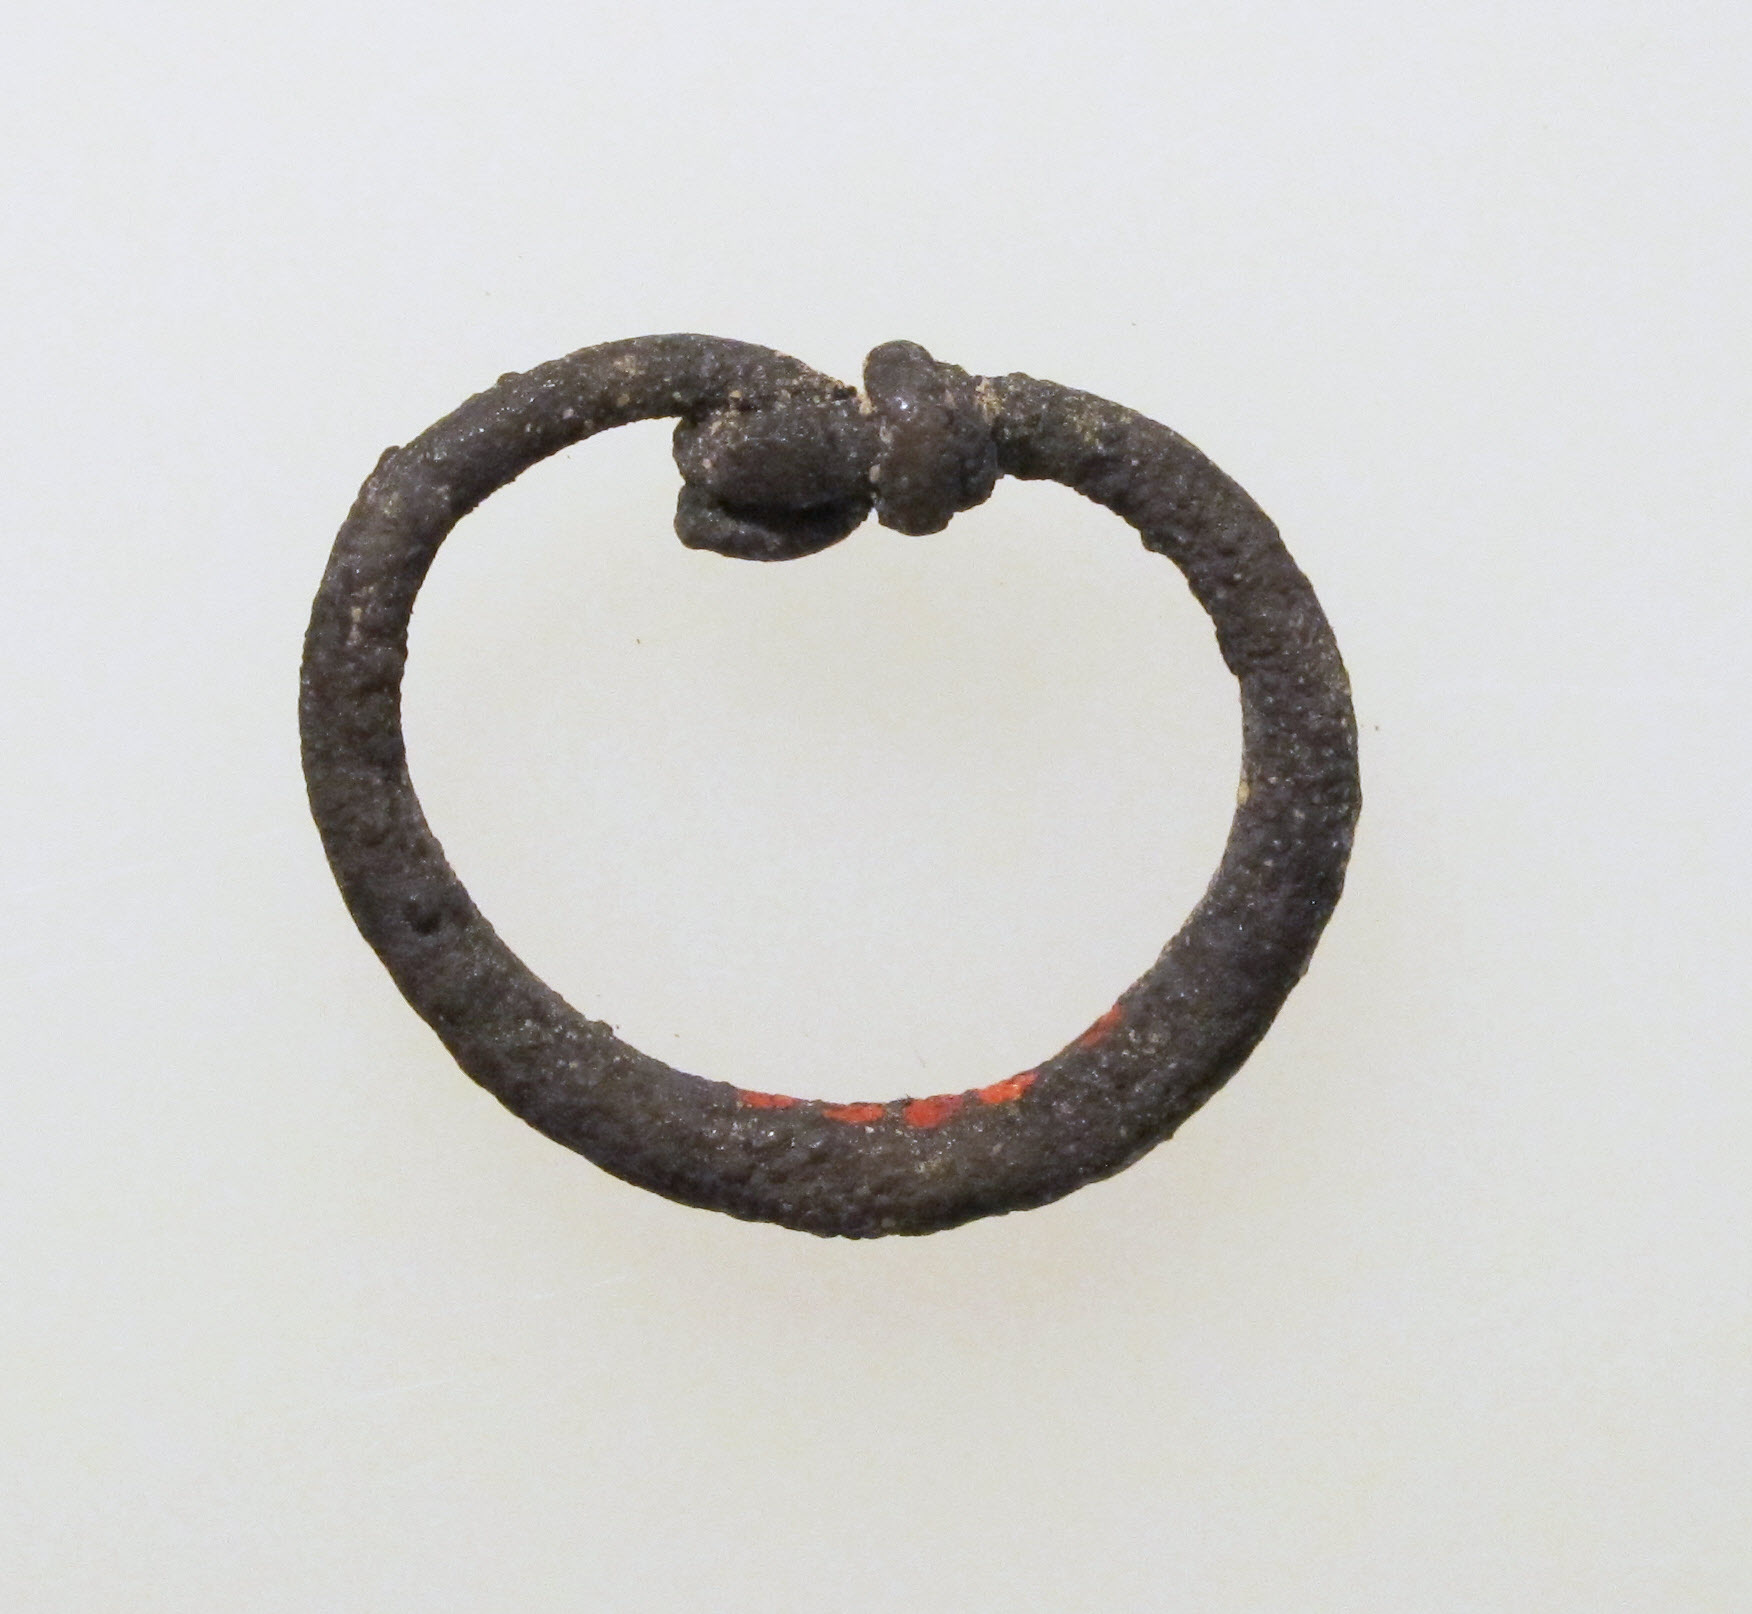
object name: earring loop type, plain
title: Earring-loop type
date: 7000 BCE-330 CE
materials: silver